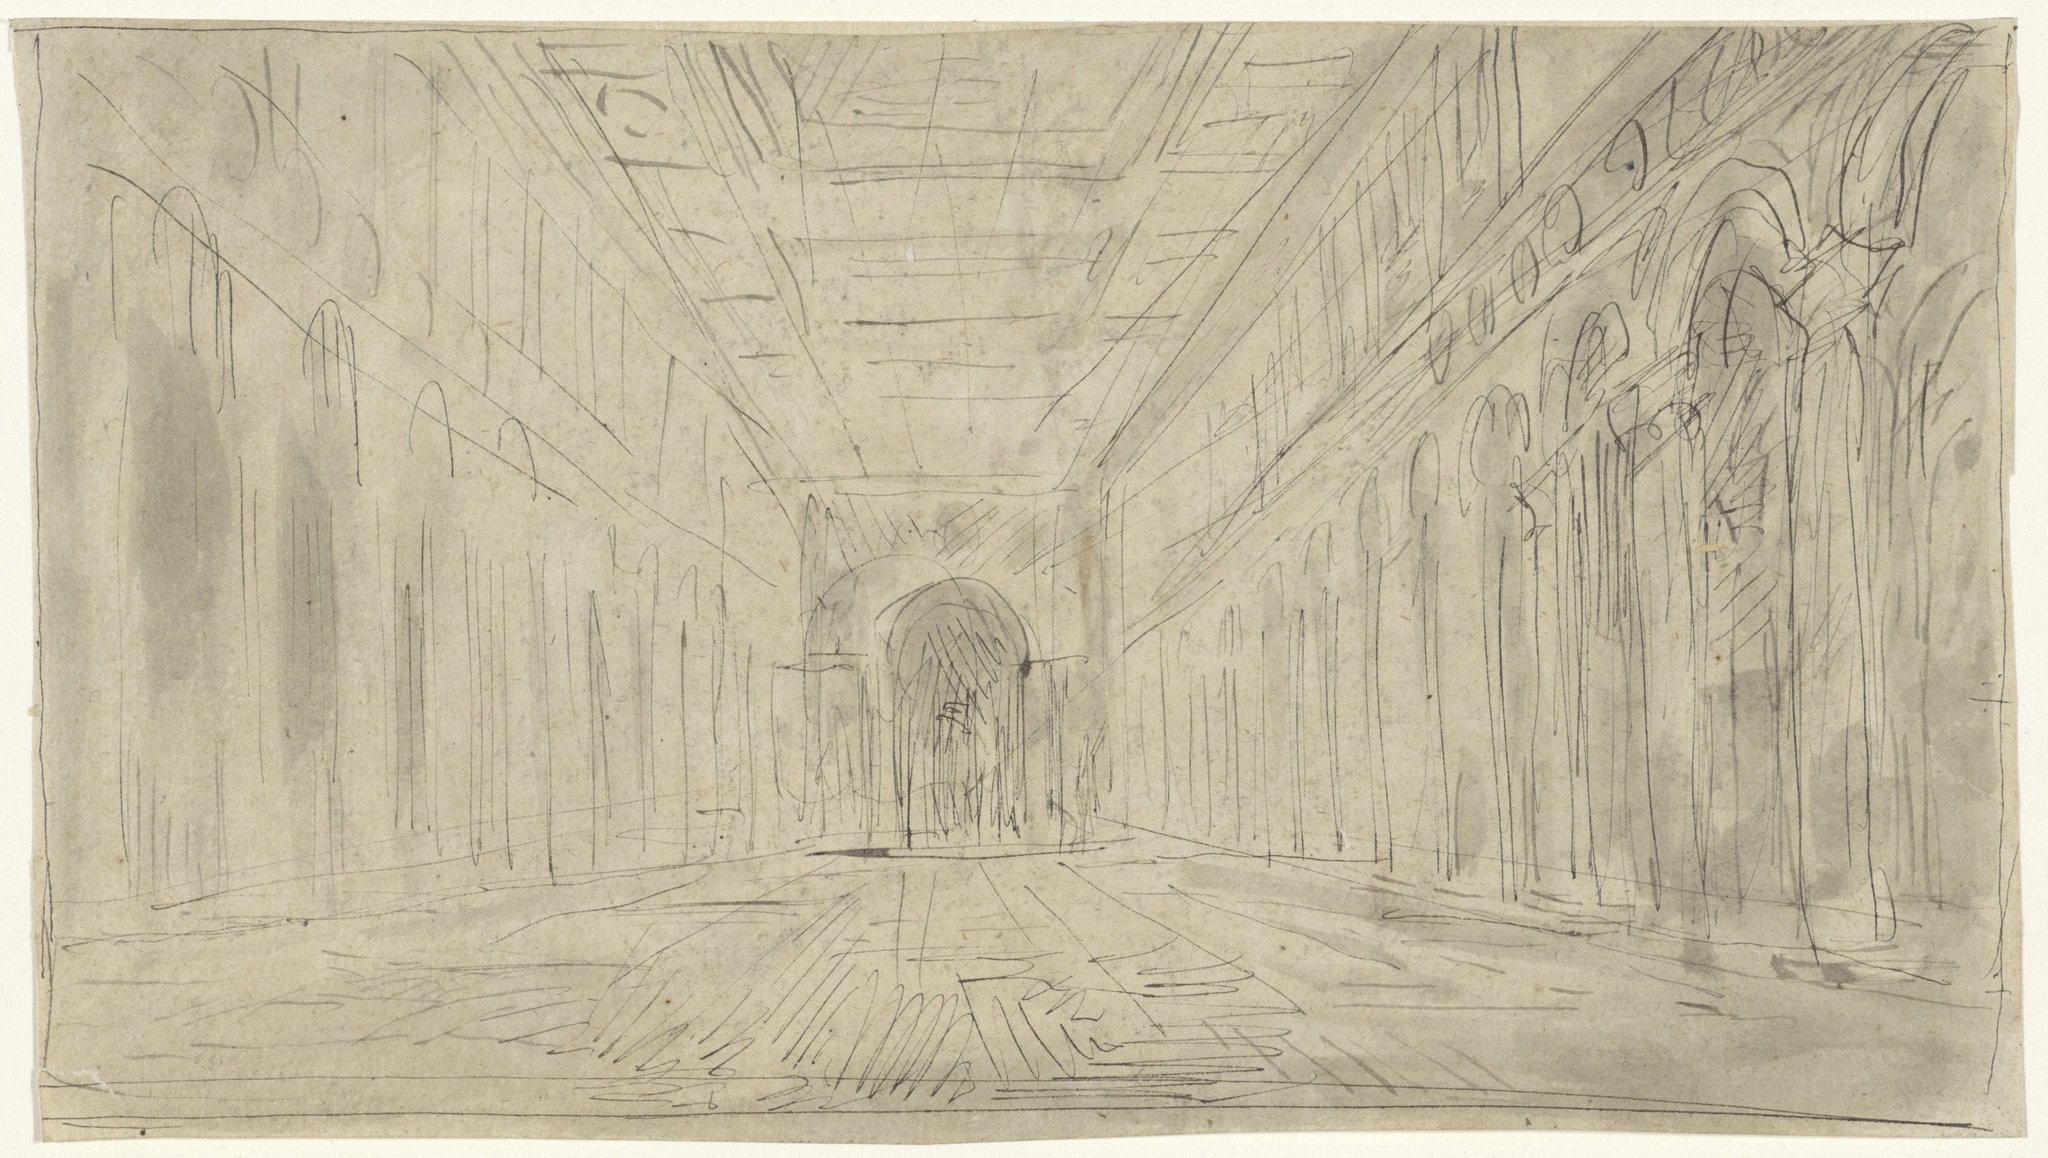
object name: drawing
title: Kerkinterieur te Rome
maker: thomas cool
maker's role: draughtsman, painter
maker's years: 1851-1904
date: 1861-1904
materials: ink, paper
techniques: brush, pen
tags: interior of church, rome